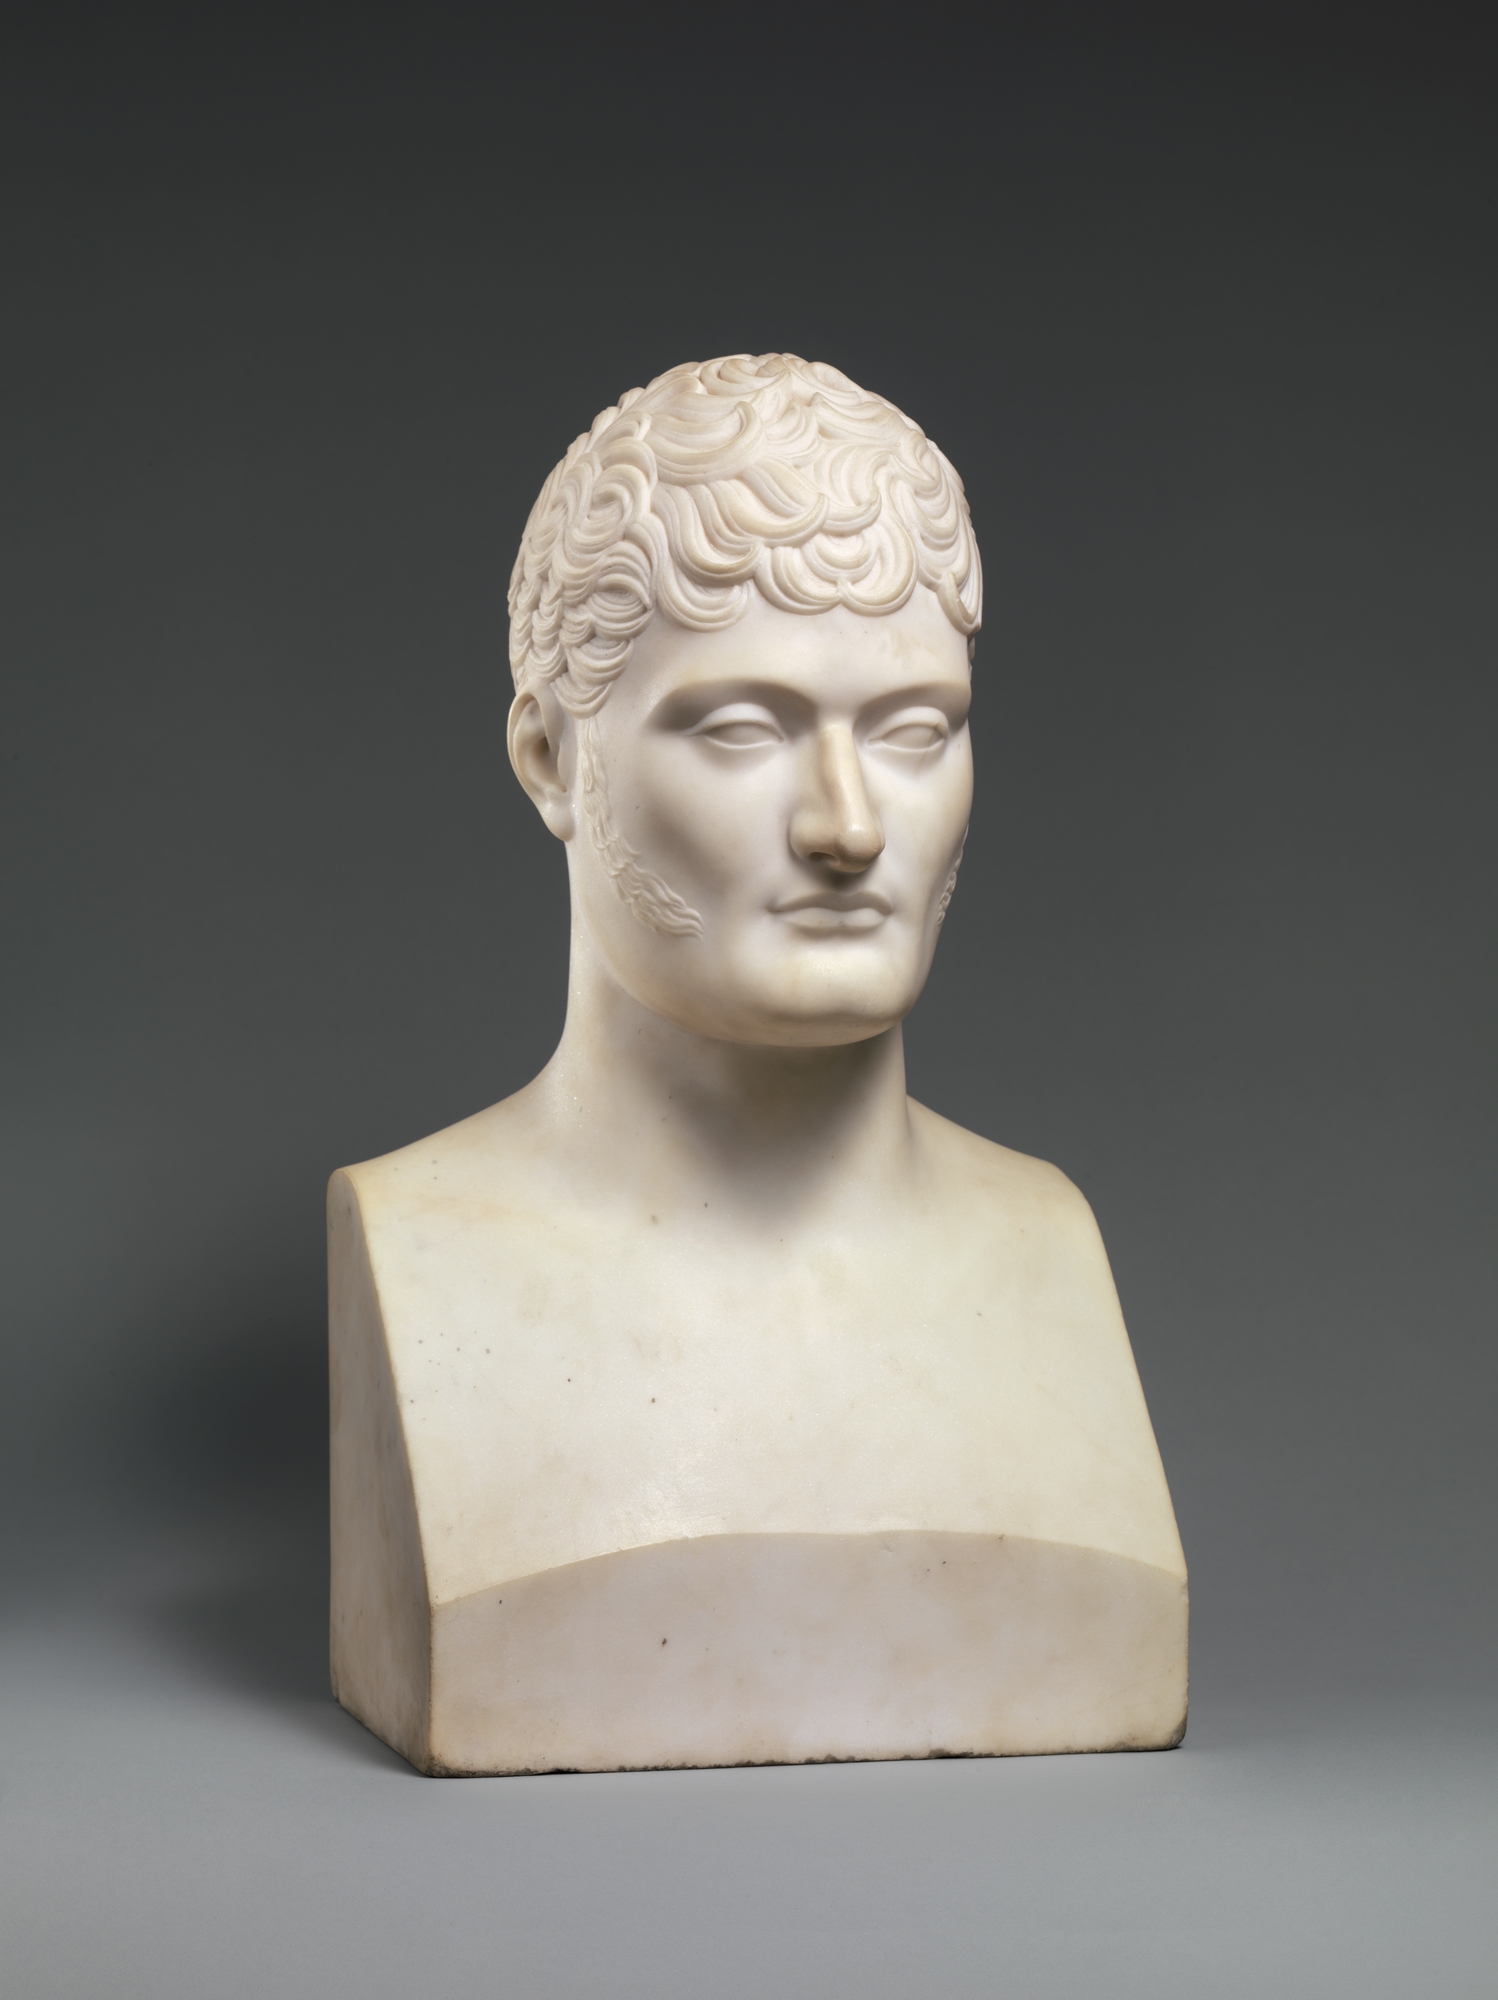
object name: bust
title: Jérôme Bonaparte (1784–1860)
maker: baron françois joseph bosio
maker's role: artist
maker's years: 1768-1845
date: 1810-1813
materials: marble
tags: men,portraits